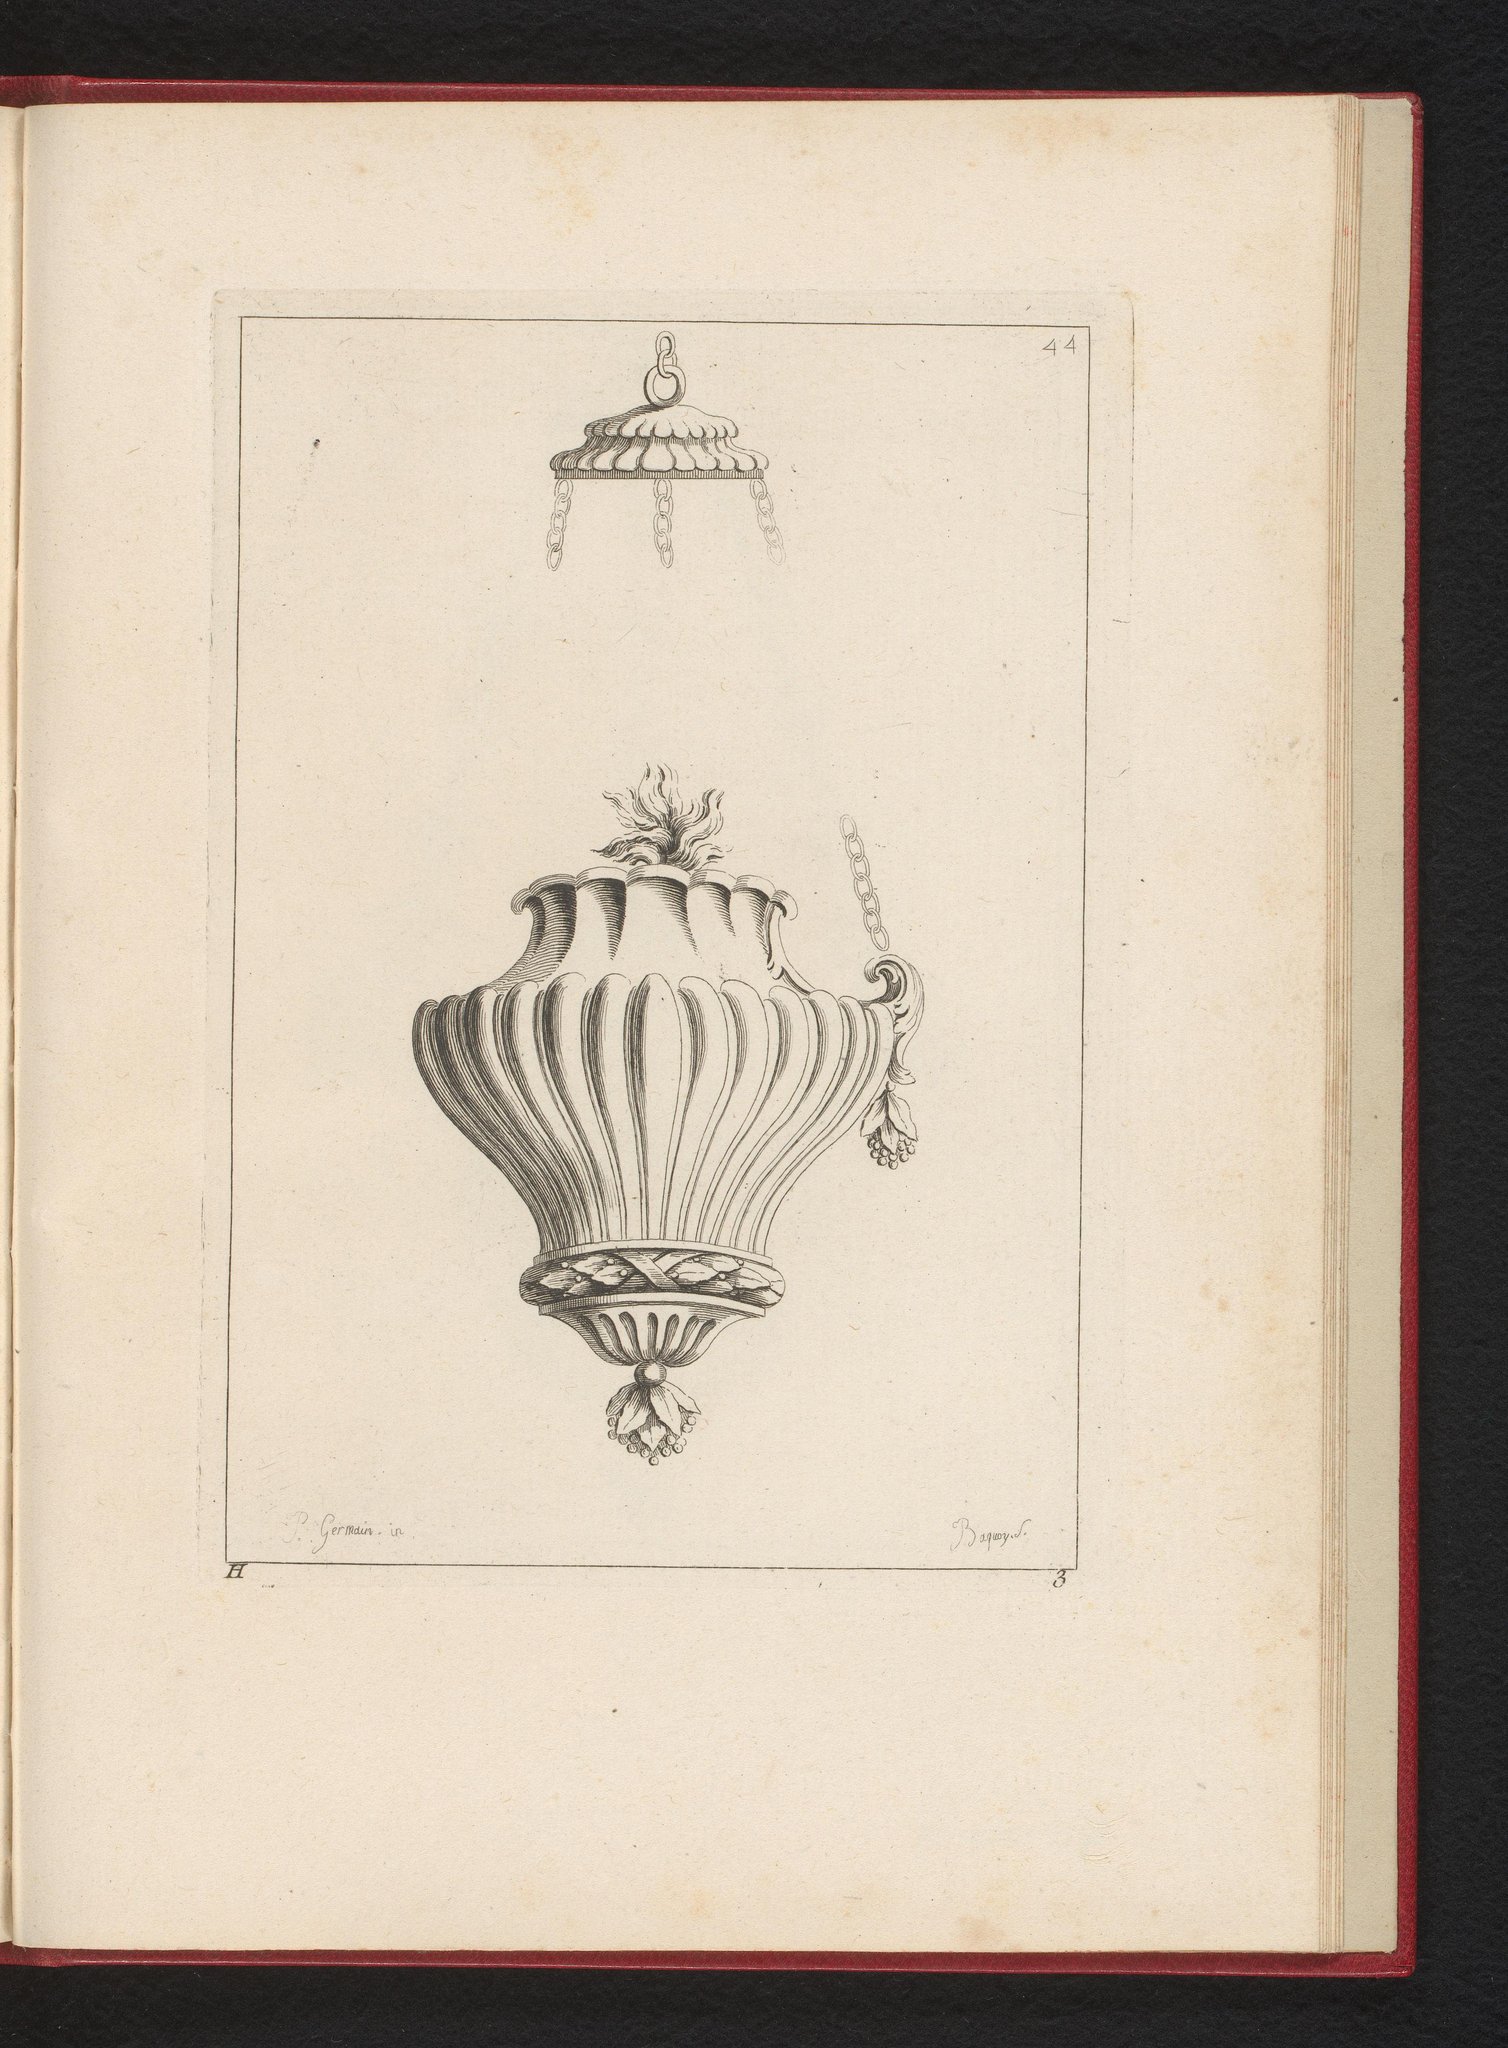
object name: print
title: Zilverwerk en edelsmeedkunst, eerste deel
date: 1748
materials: paper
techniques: etching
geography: paris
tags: altarlamp, altar fire, jeweller, goldsmith, silversmith, oil-lamp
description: Deze prent maakt deel uit van een album.